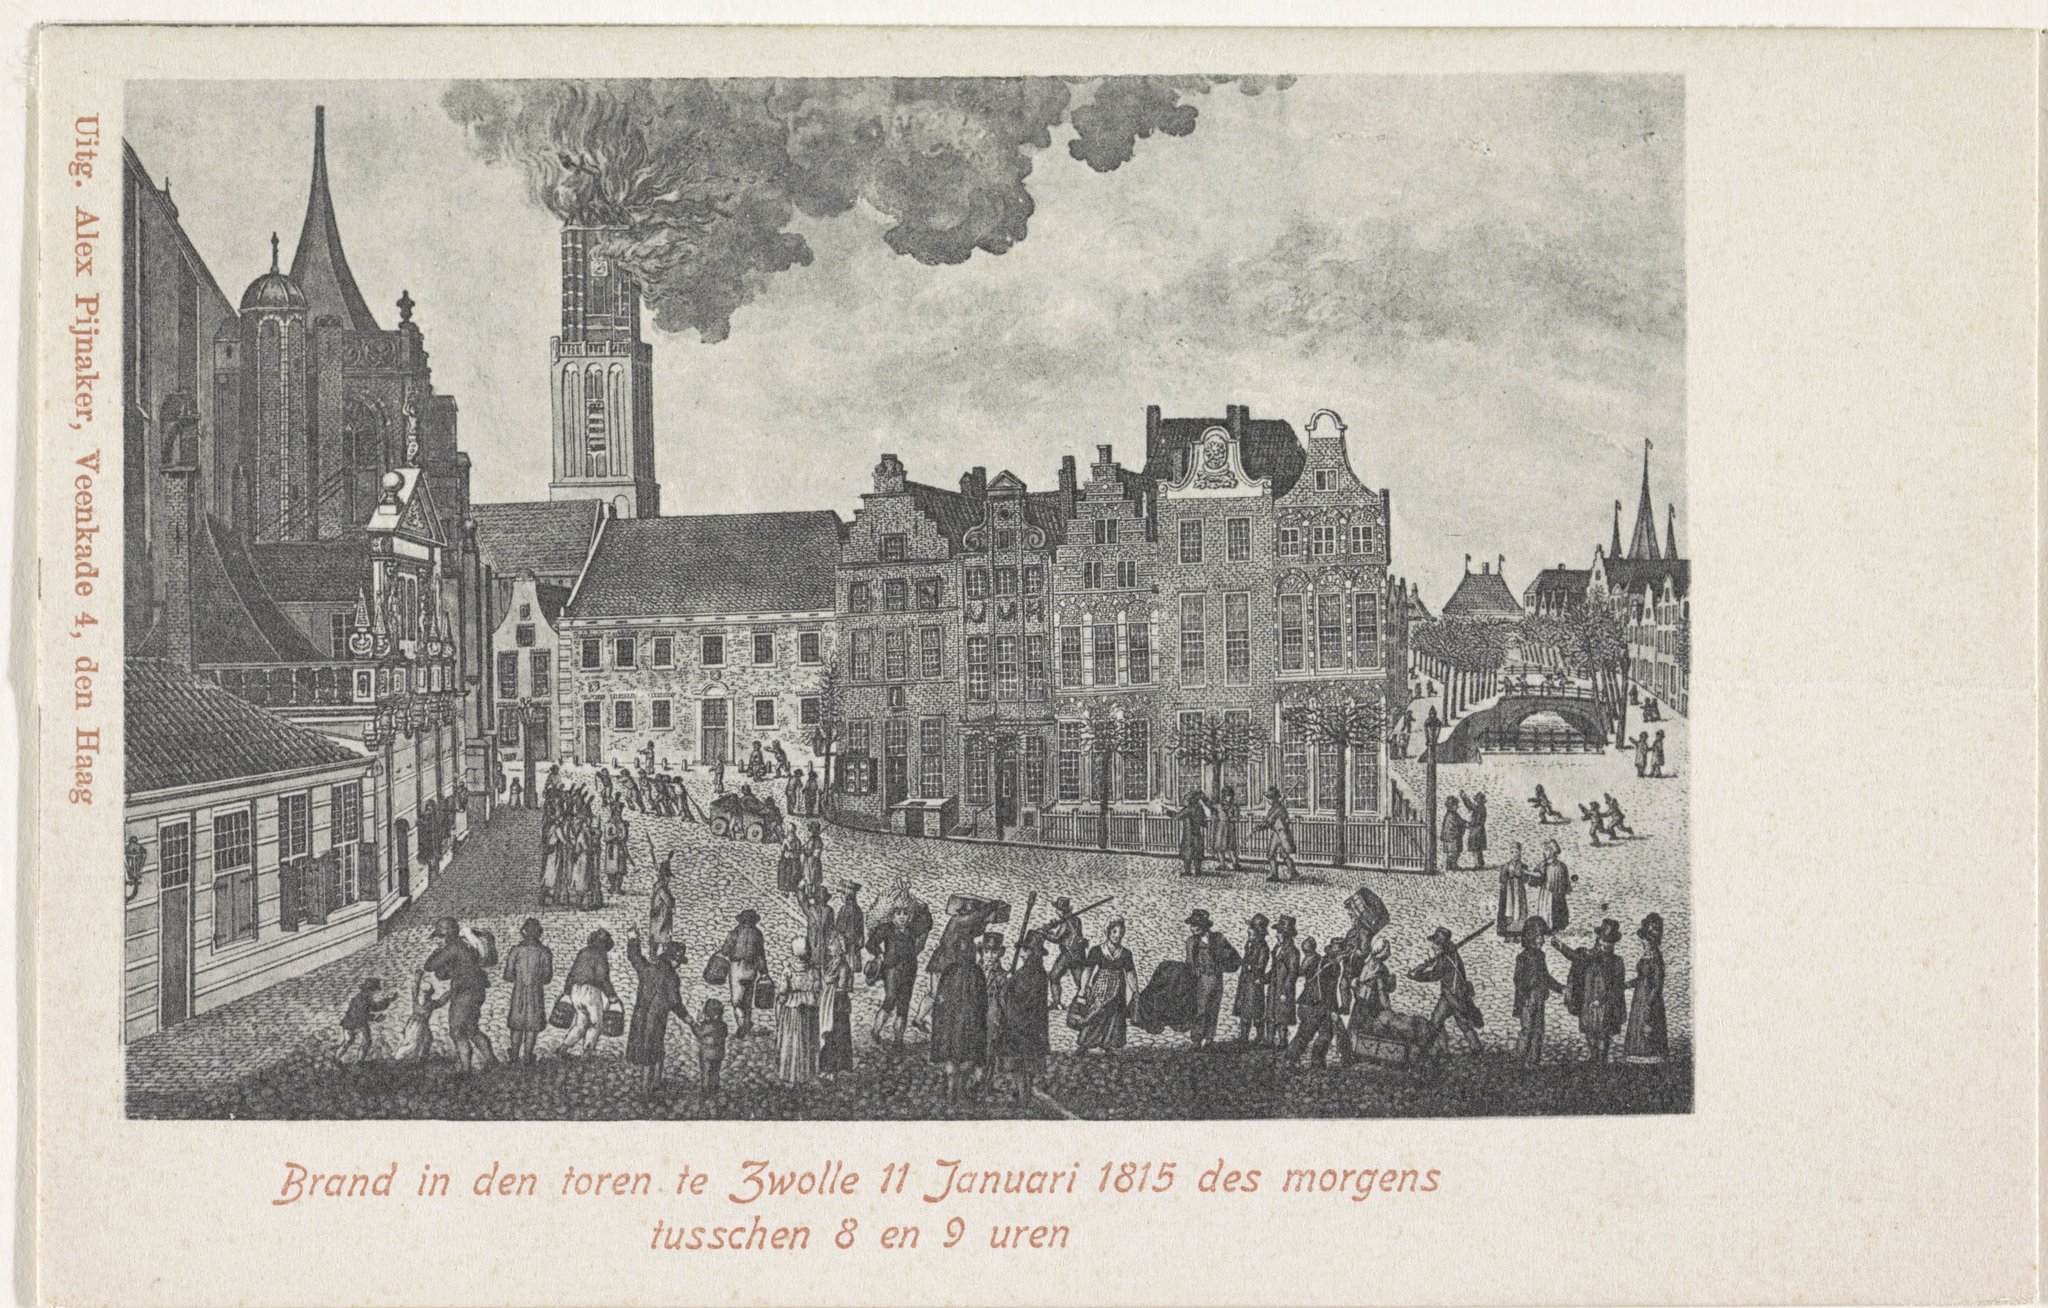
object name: ansichtkaart, prentbriefkaart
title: Brand in de toren van de basiliek van Onze-Lieve-Vrouw-Tenhemelopneming te Zwolle, 1815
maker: alex pijnaker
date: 1900-1905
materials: paper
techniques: photochemical processes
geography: netherlands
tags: on fire, ablaze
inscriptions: collector's mark: Lugt 2228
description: Reproductie van de prent uit 1815 met de brand in de Peperbus, de toren behorende bij de basiliek van Onze-Lieve-Vrouw-Tenhemelopneming, te Zwolle op 11 januari 1815.